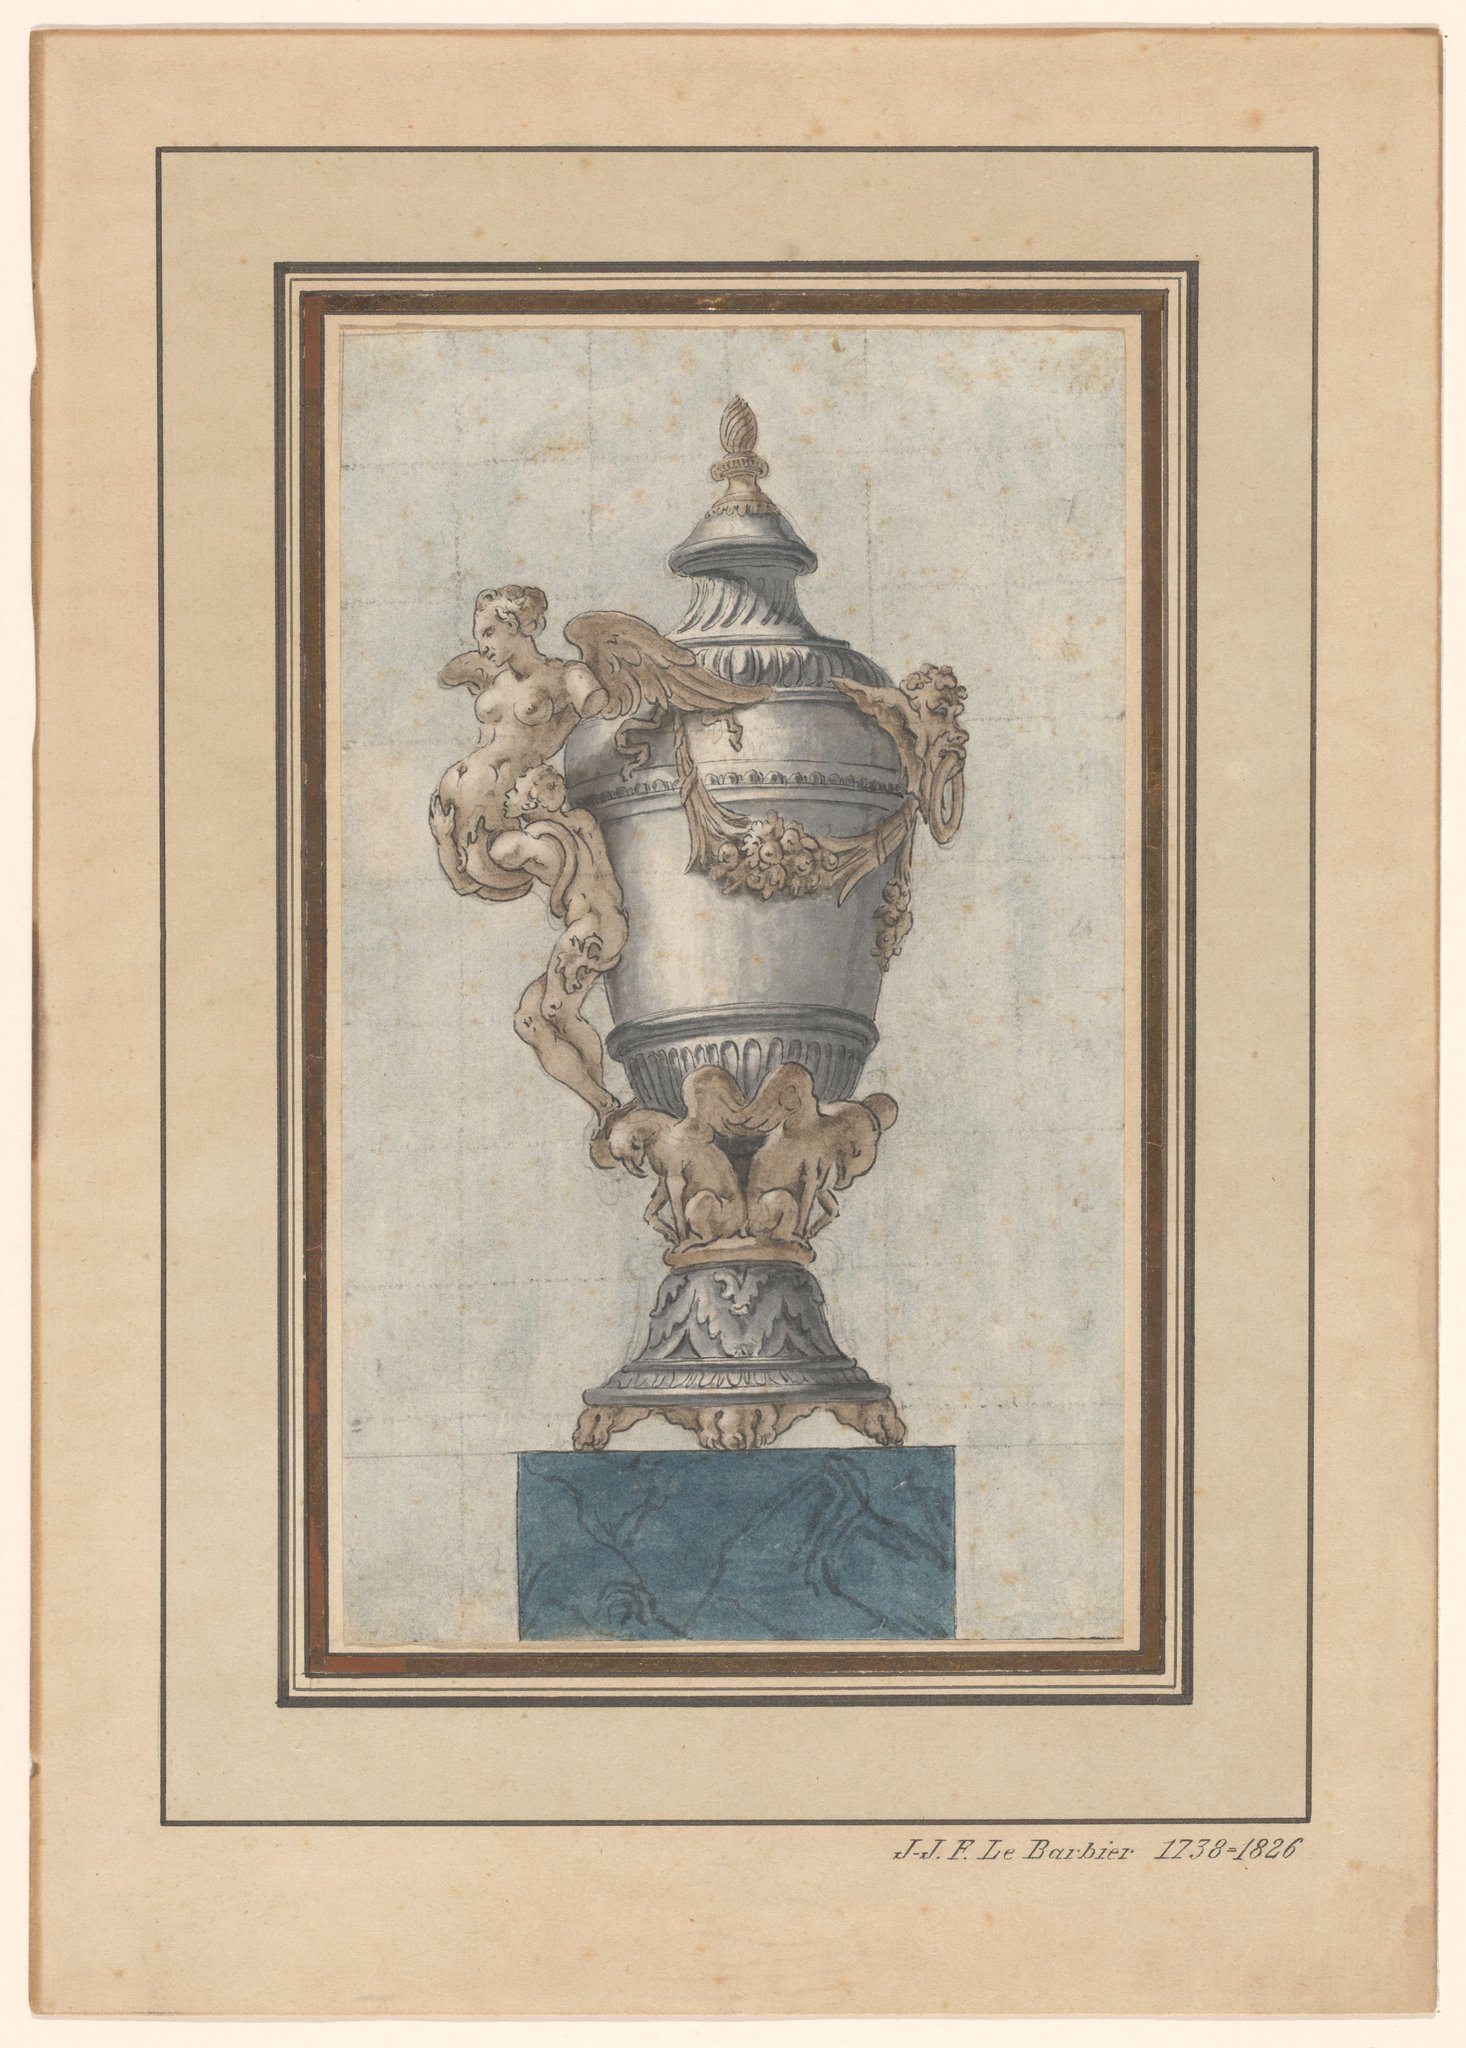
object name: drawing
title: Kan, vermoedelijk van gedeeltelijk verguld zilver, op een marmeren sokkel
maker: Anonymous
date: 1780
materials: graphite, ink, paper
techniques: aquarelle, pen, drawing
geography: france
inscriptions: inscription: ‘J.J.F. Le Barbier 1738-1826’